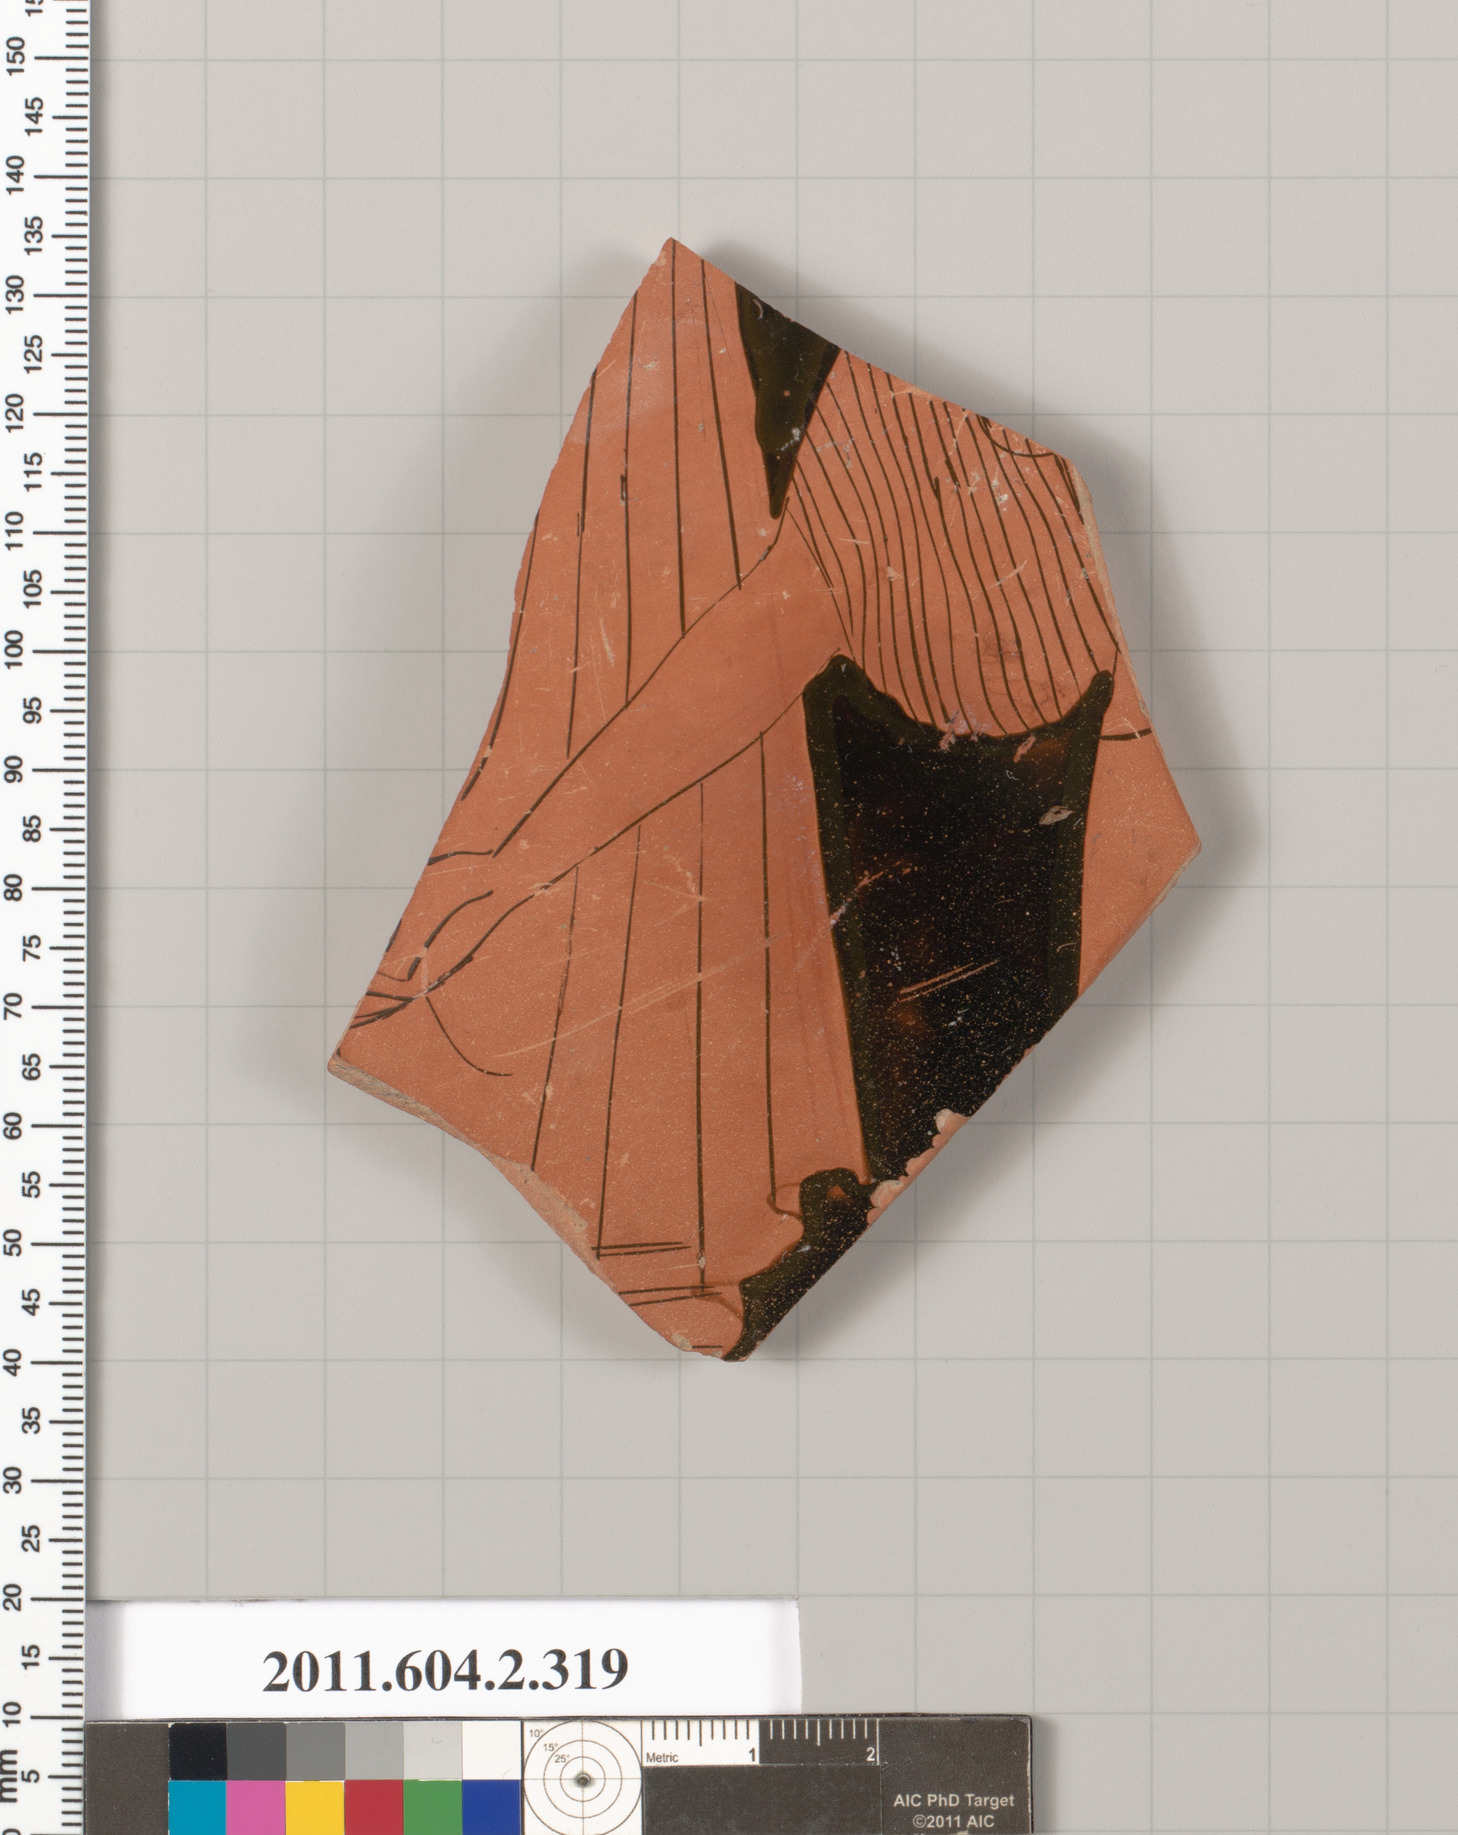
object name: column krater fragment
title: Terracotta fragment of a column-krater (bowl for mixing wine and water)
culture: greek, attic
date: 460-450 BCE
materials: terracotta